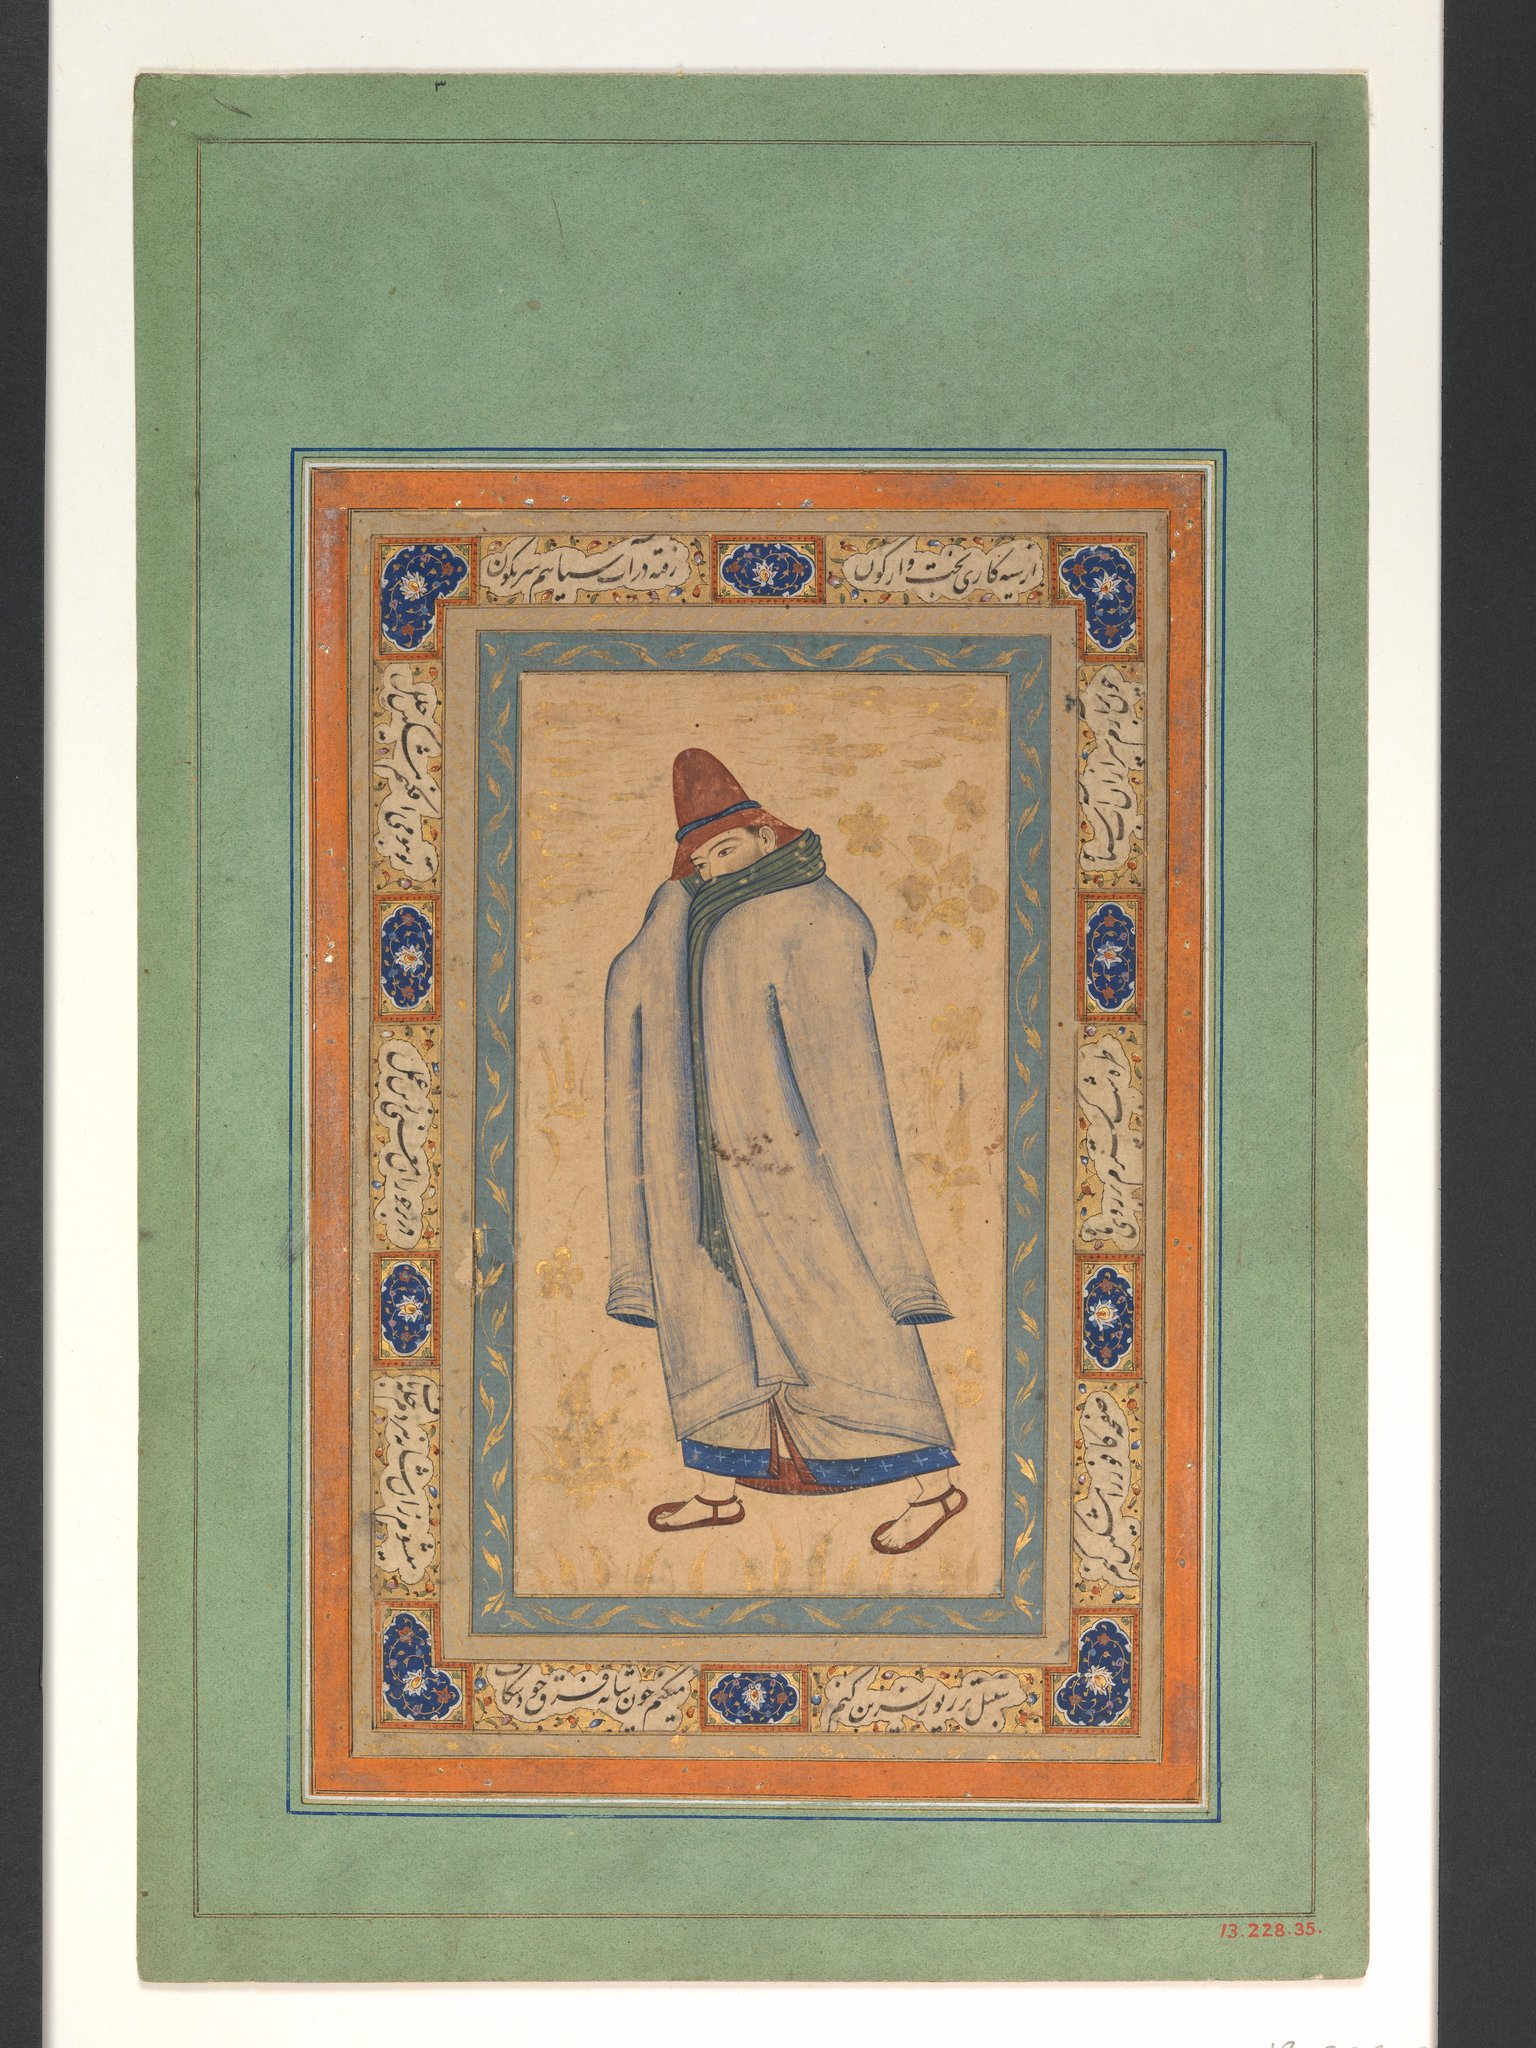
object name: illustrated album leaf or single work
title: A Dervish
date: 1567-1633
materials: gold, ink, paper, watercolor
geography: iran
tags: men